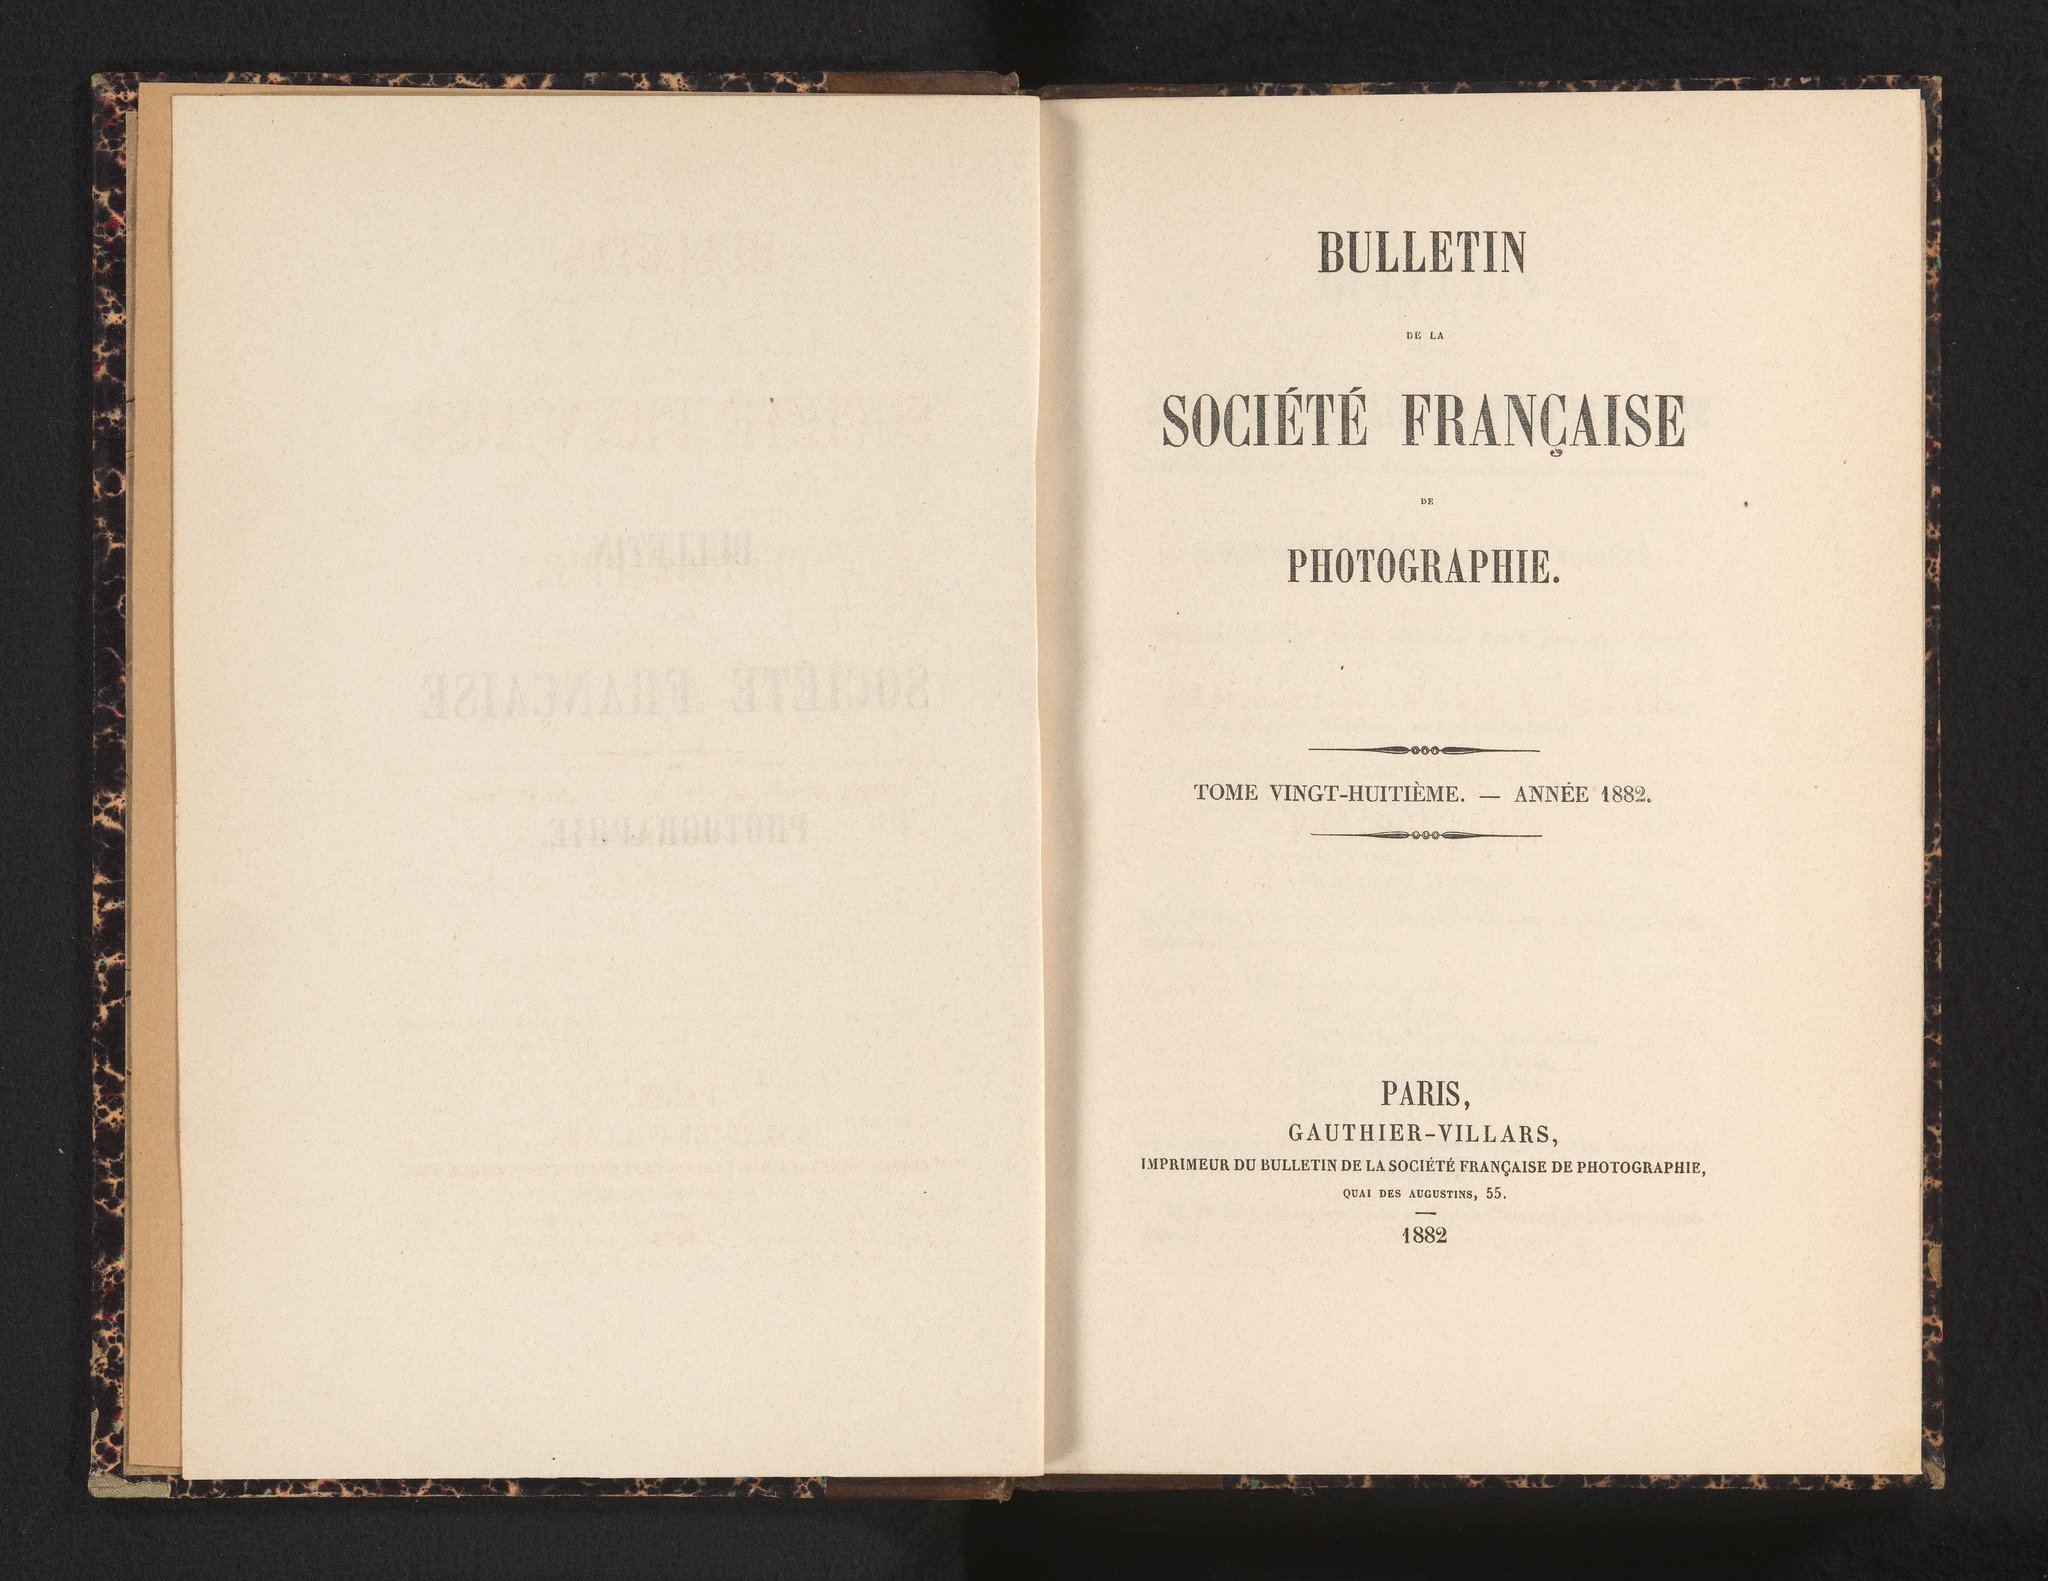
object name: book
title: Bulletin de la Société française de photographie. Tome vingt-huitième - année 1882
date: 1882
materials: paper, cardboard, leather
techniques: photograph, letterpress printing, marbling, marbled paper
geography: paris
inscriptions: number: ‘28’